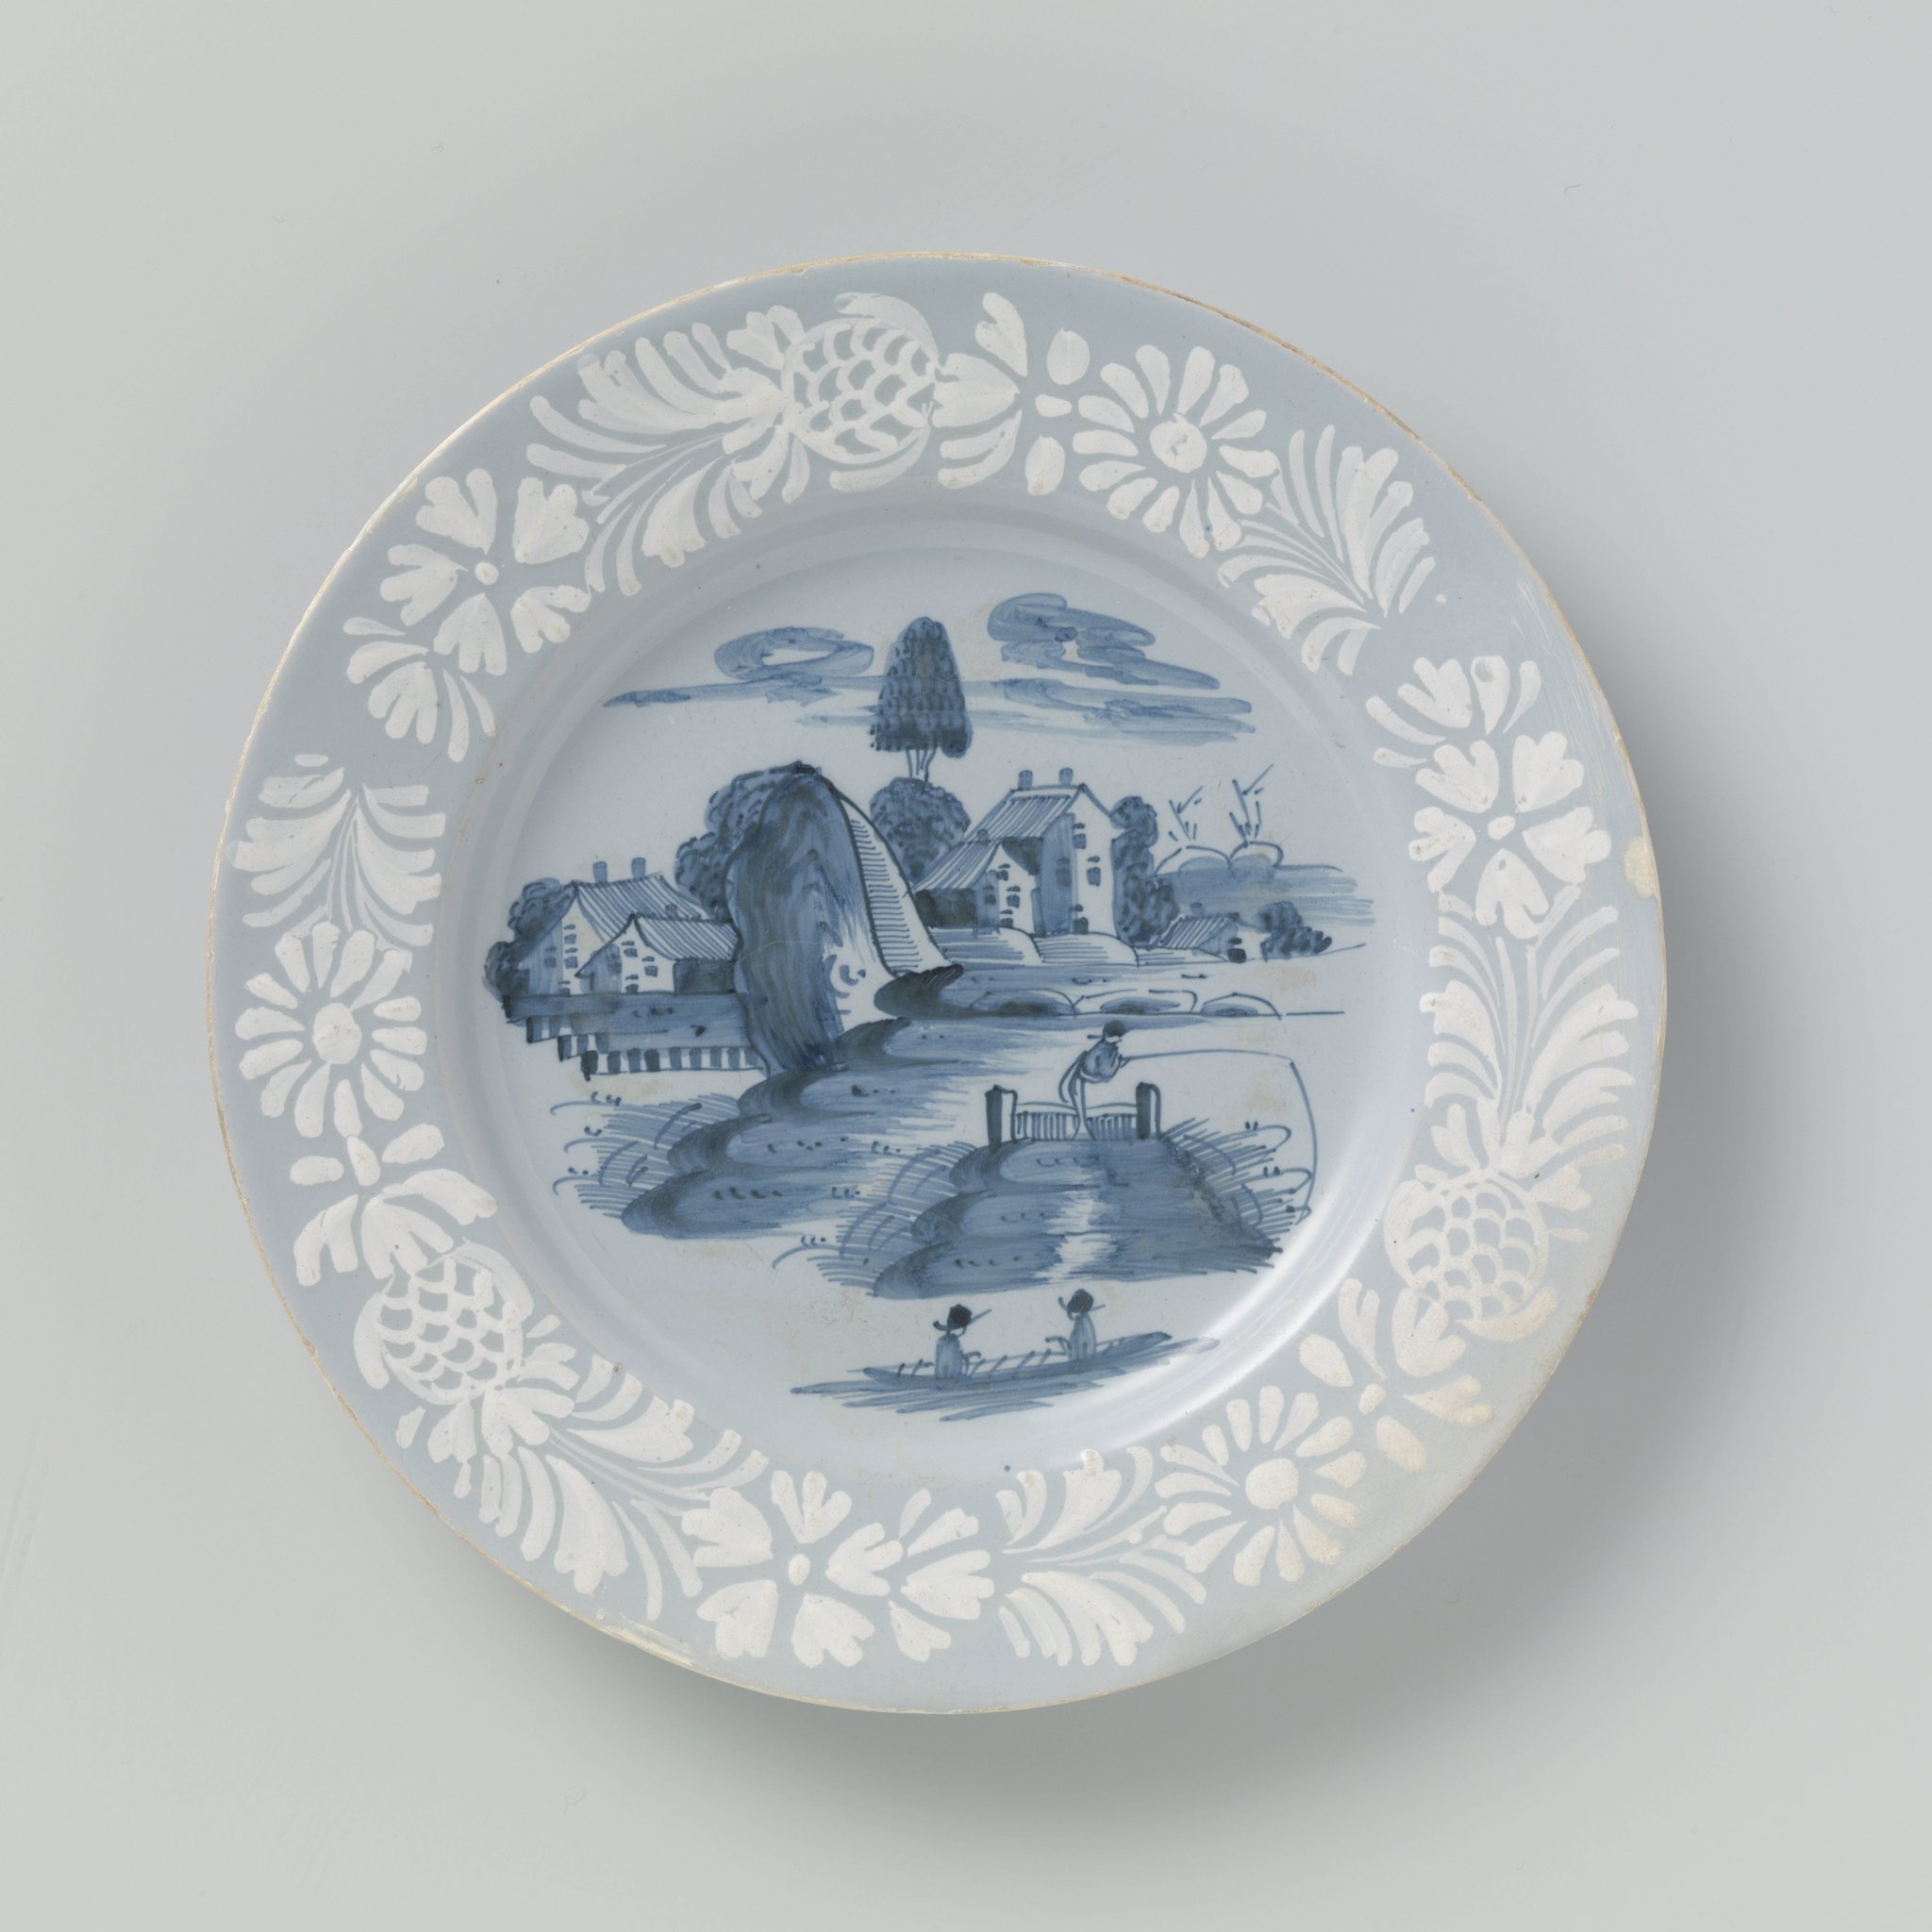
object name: plate dish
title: Bord, het plat beschilderd met een landschap met huizen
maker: Anonymous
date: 1760-1770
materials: earthenware, glaze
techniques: painted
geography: bristol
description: Rond bord van beschilderde faience. Het bord heeft een lichtblauwe fond. Op het plat is in blauw een landschap met huizen geschilderd en op de rand witte bloemen. Bij het bord horen drie identieke borden (BK-NM-11334-A, BK-NM-11334-C en BK-NM-11334-D).